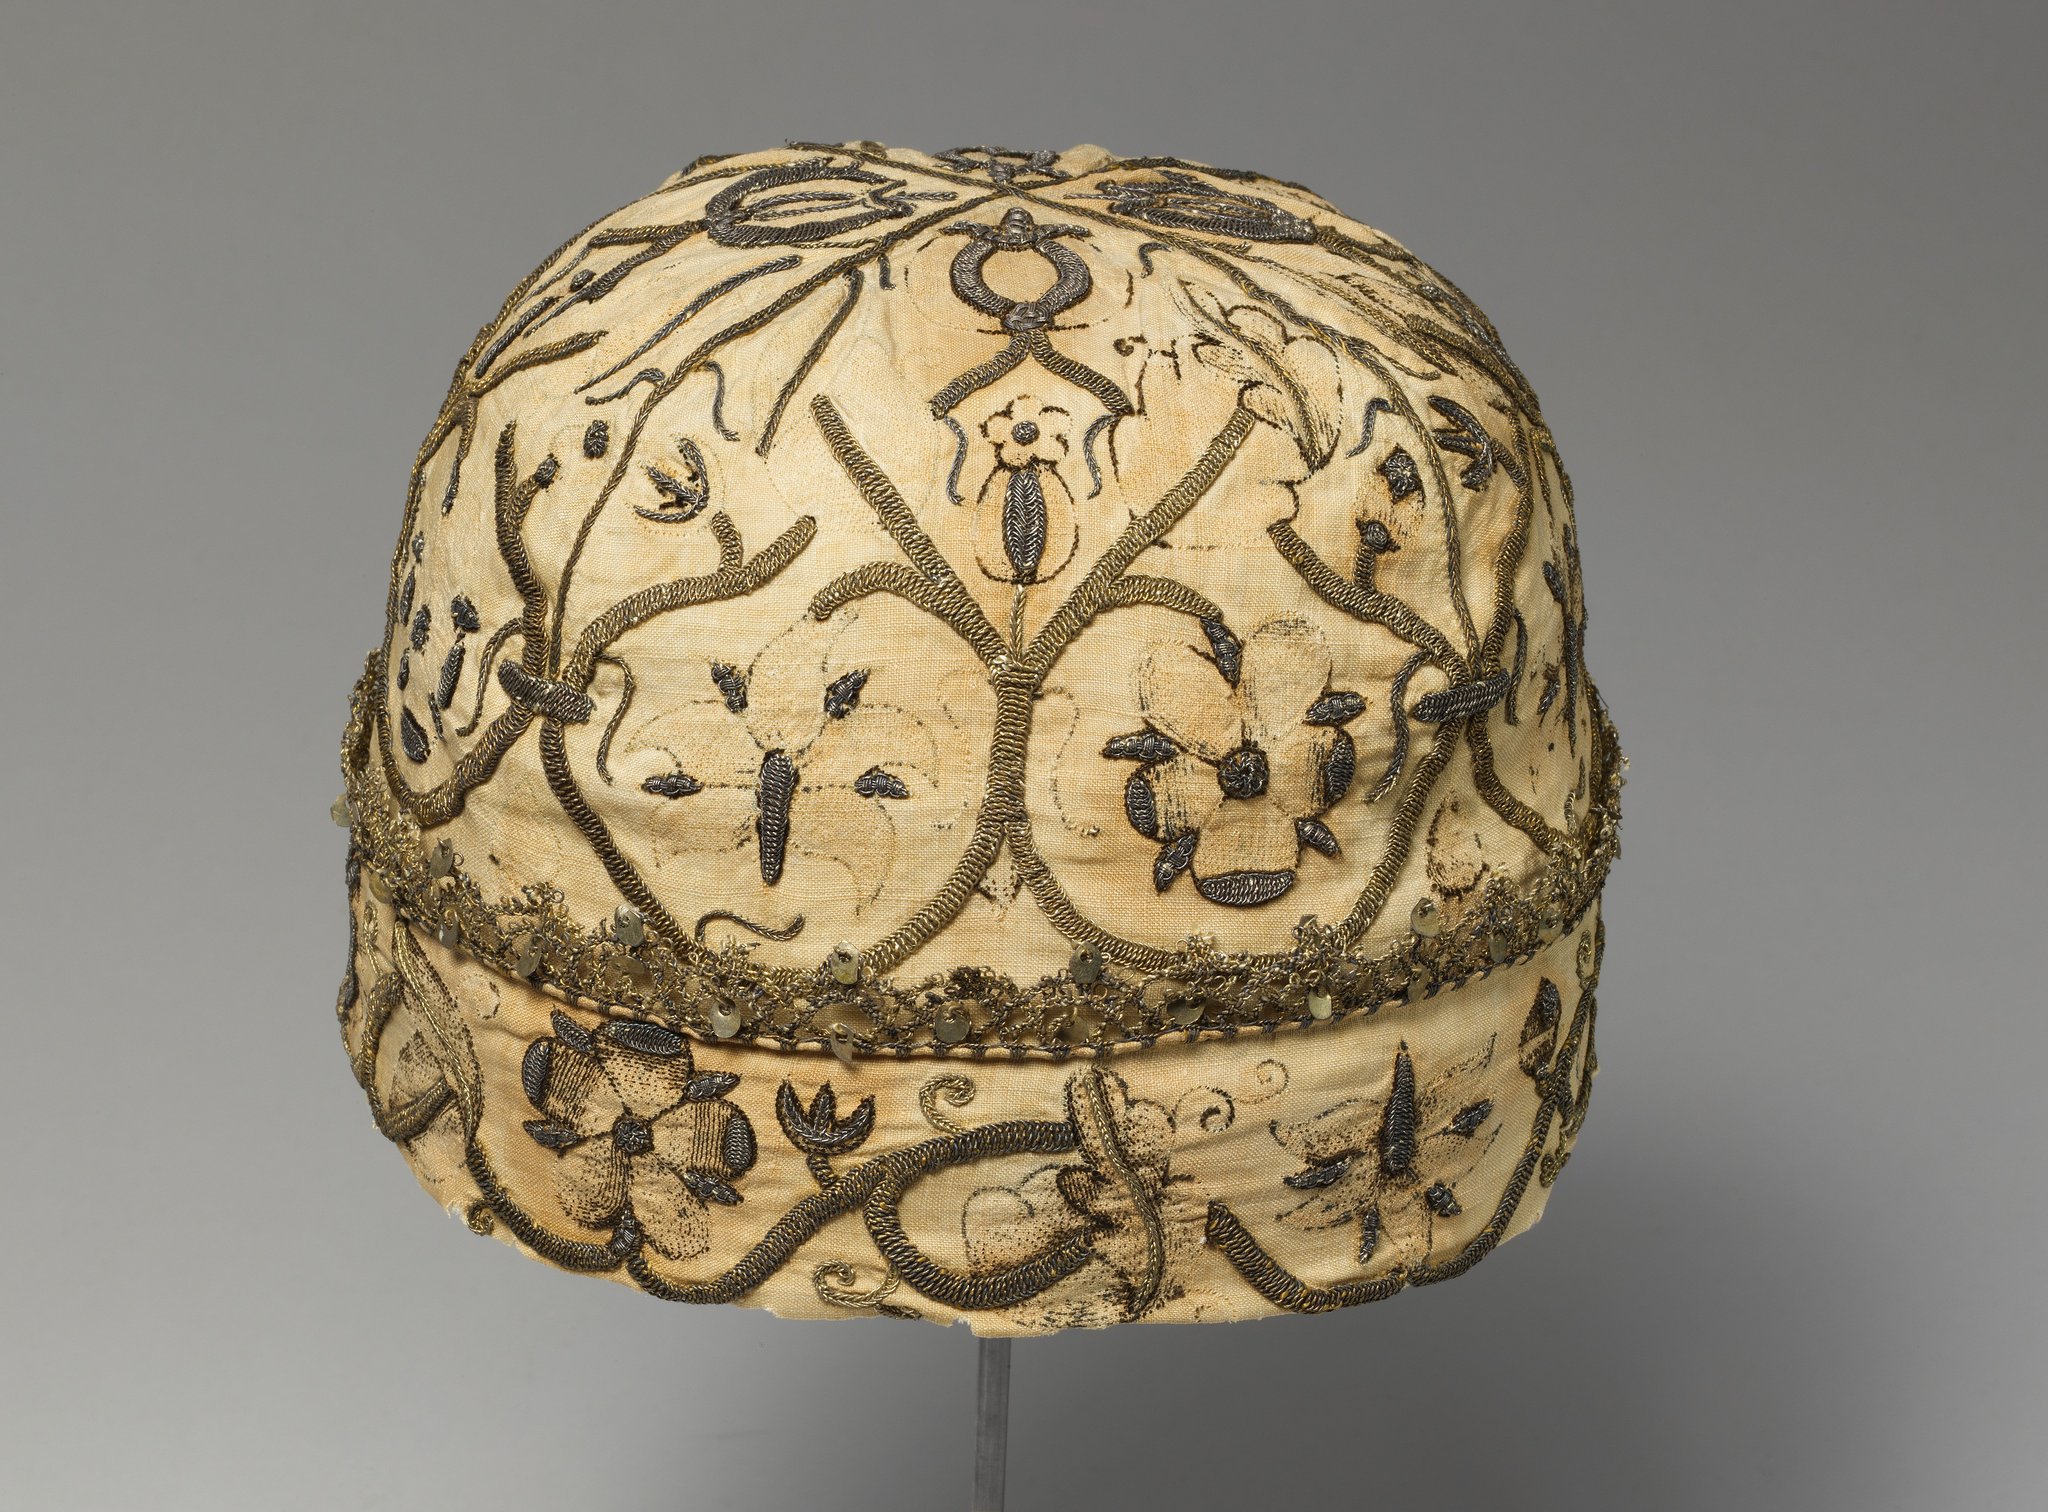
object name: night cap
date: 1567-1633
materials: linen, metal, metal thread, silk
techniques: lace, stitching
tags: flowers